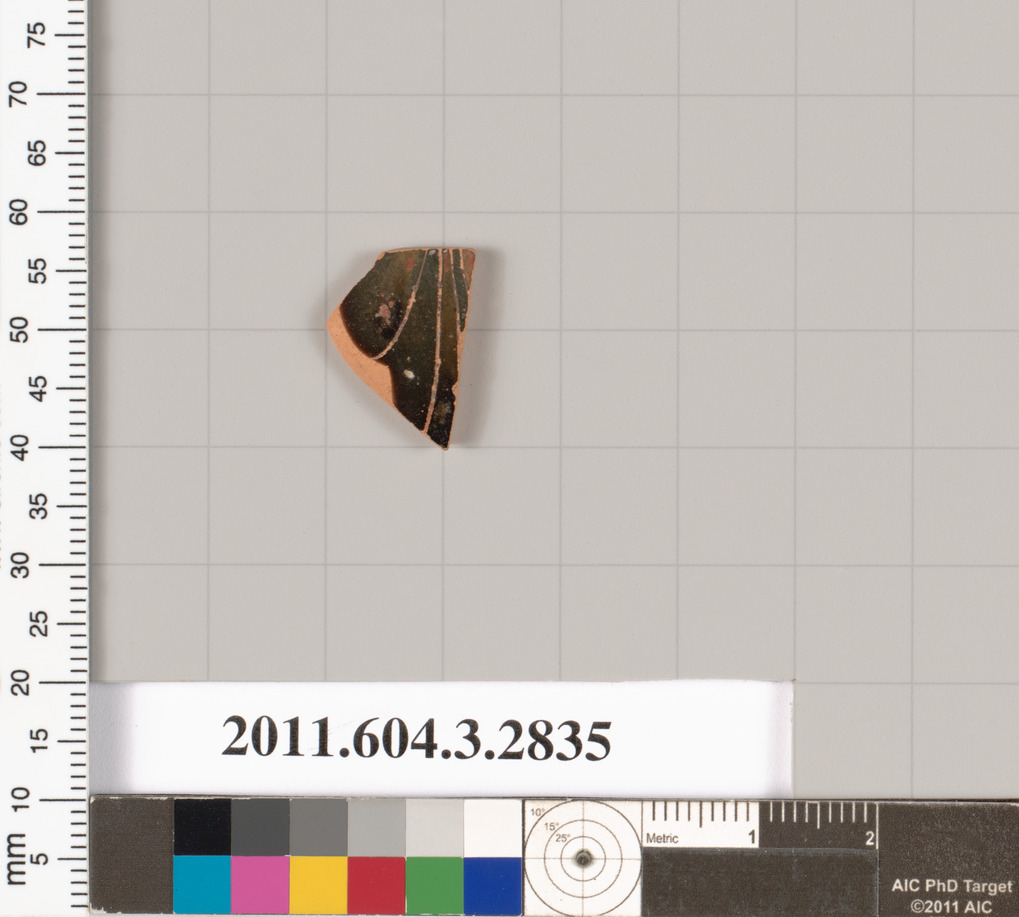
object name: undetermined closed shape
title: Terracotta fragment of a closed shape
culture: greek, attic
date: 510-500 BCE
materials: terracotta